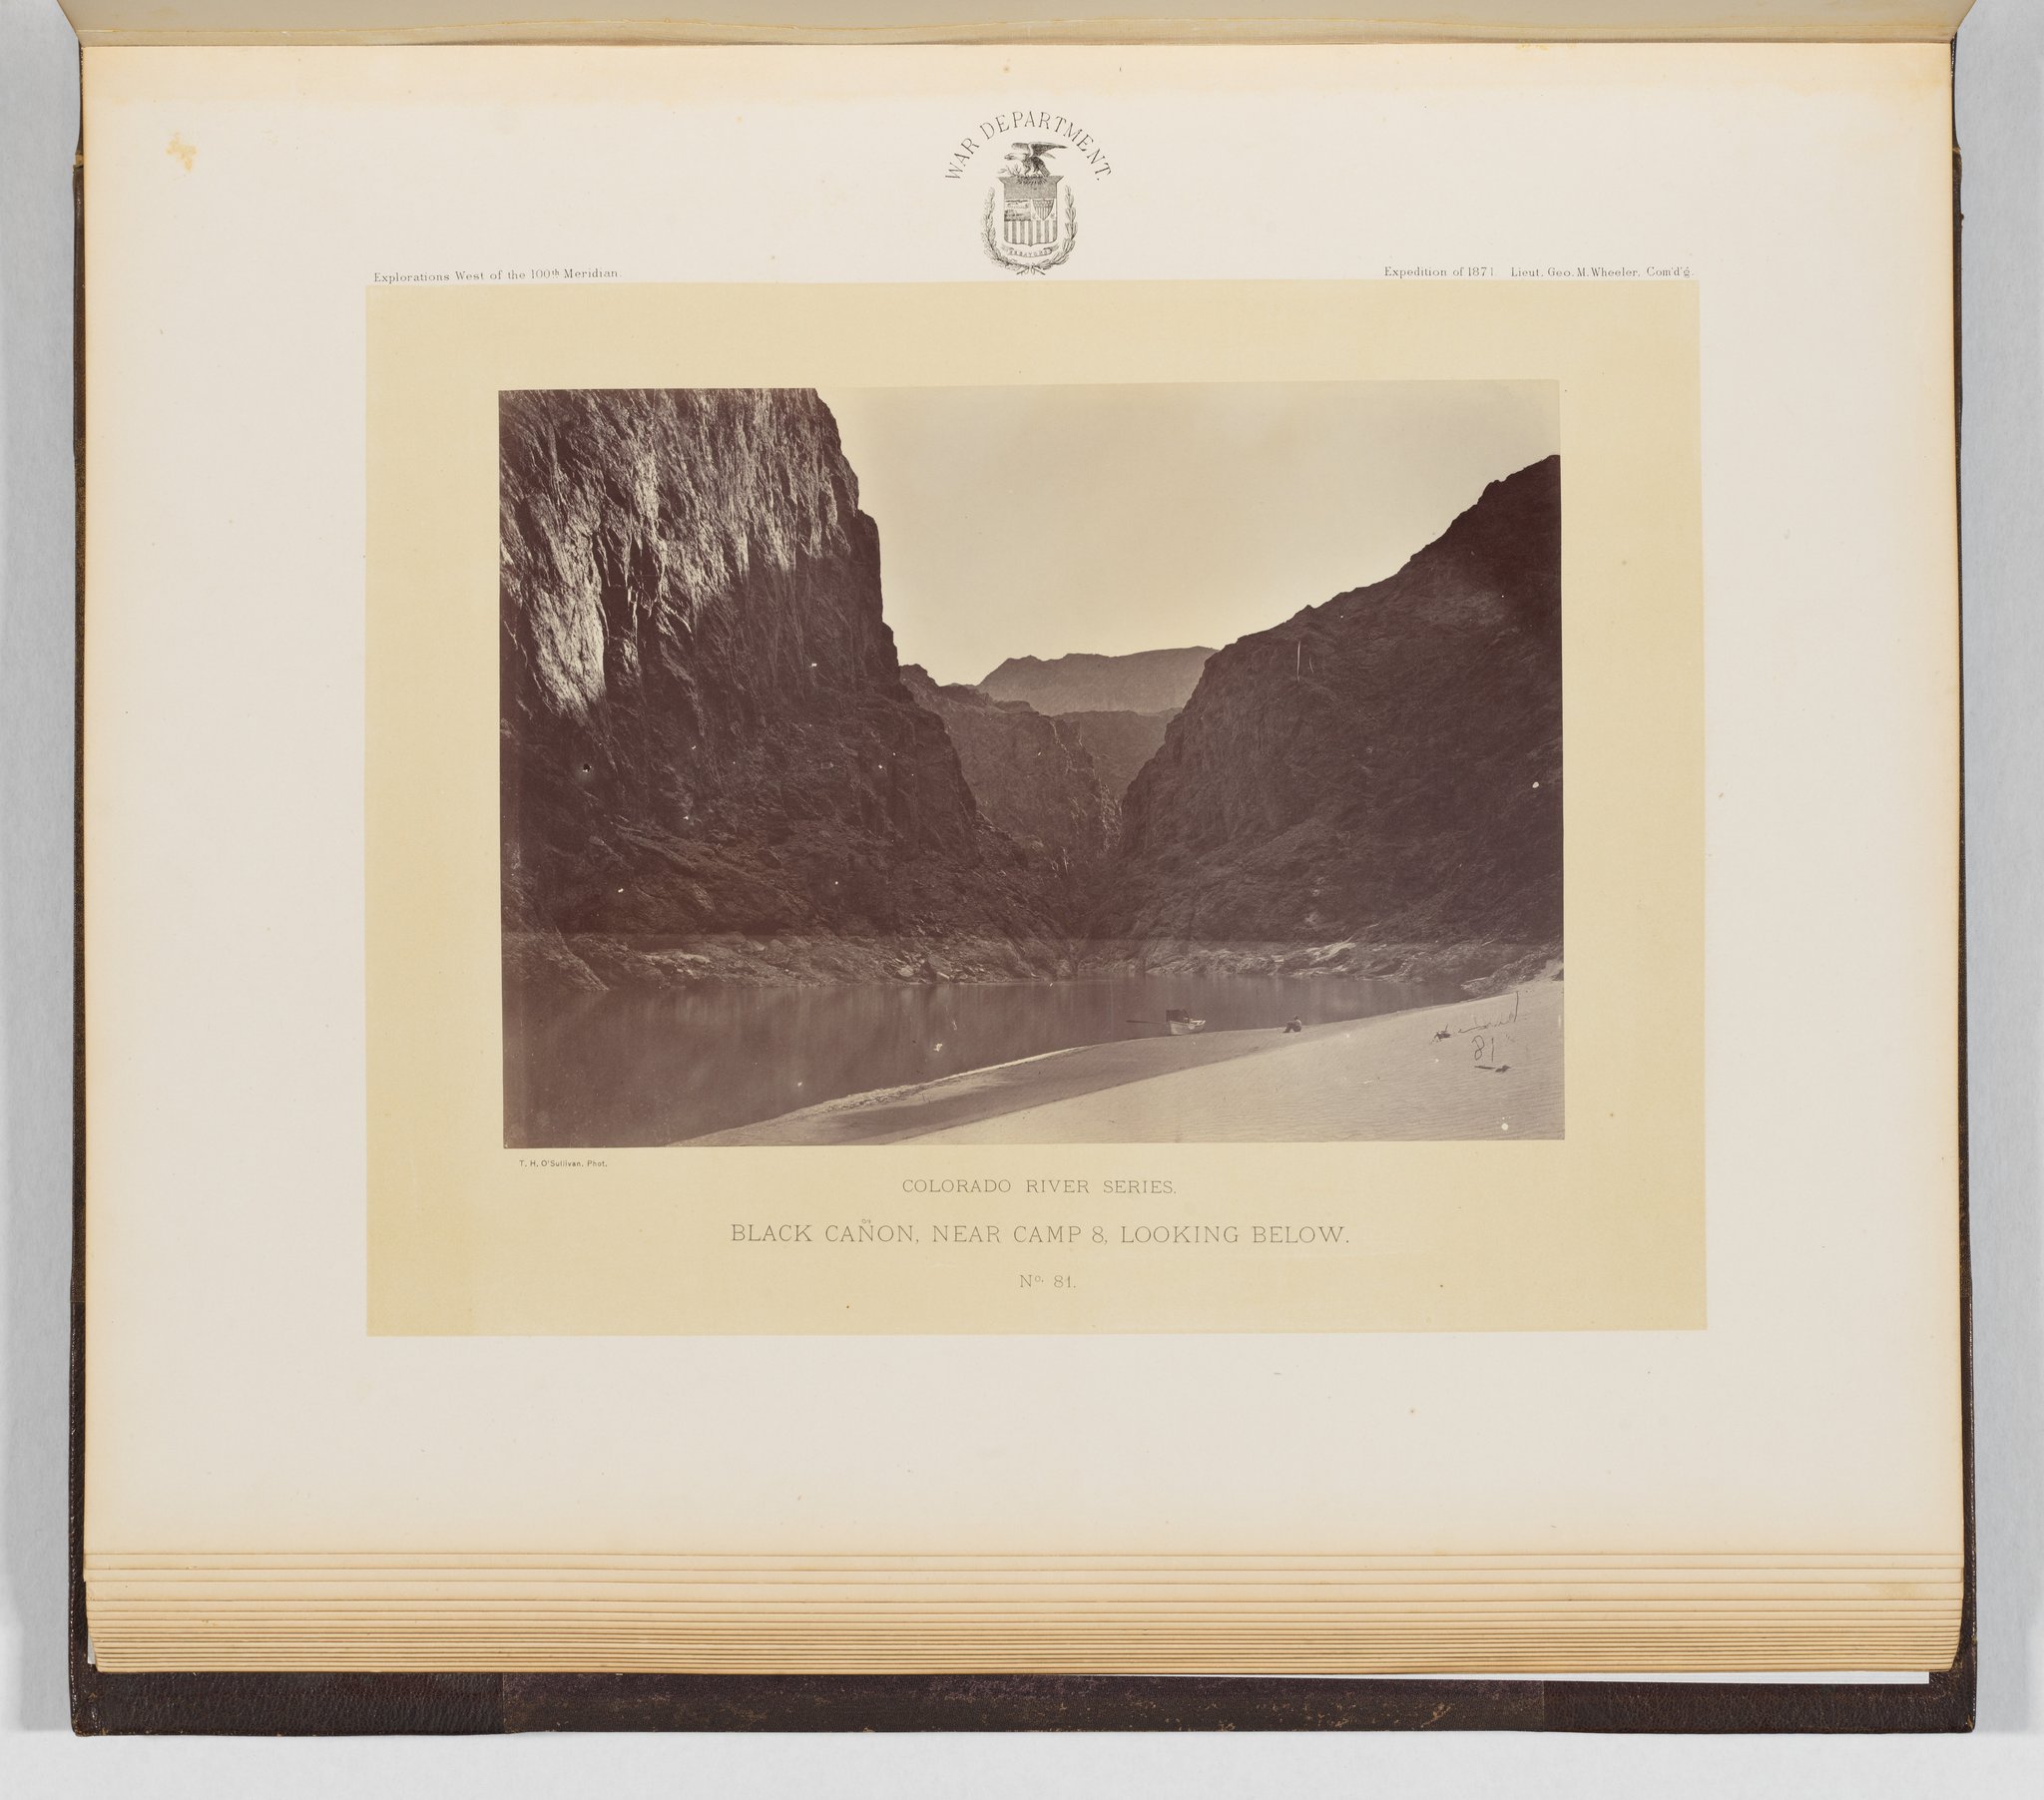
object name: photograph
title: Black Cañon, Near Camp 8, Looking Below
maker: timothy h. o'sullivan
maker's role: artist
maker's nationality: american, born ireland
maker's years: 1840-1882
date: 1871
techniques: albumen silver print, glass negative